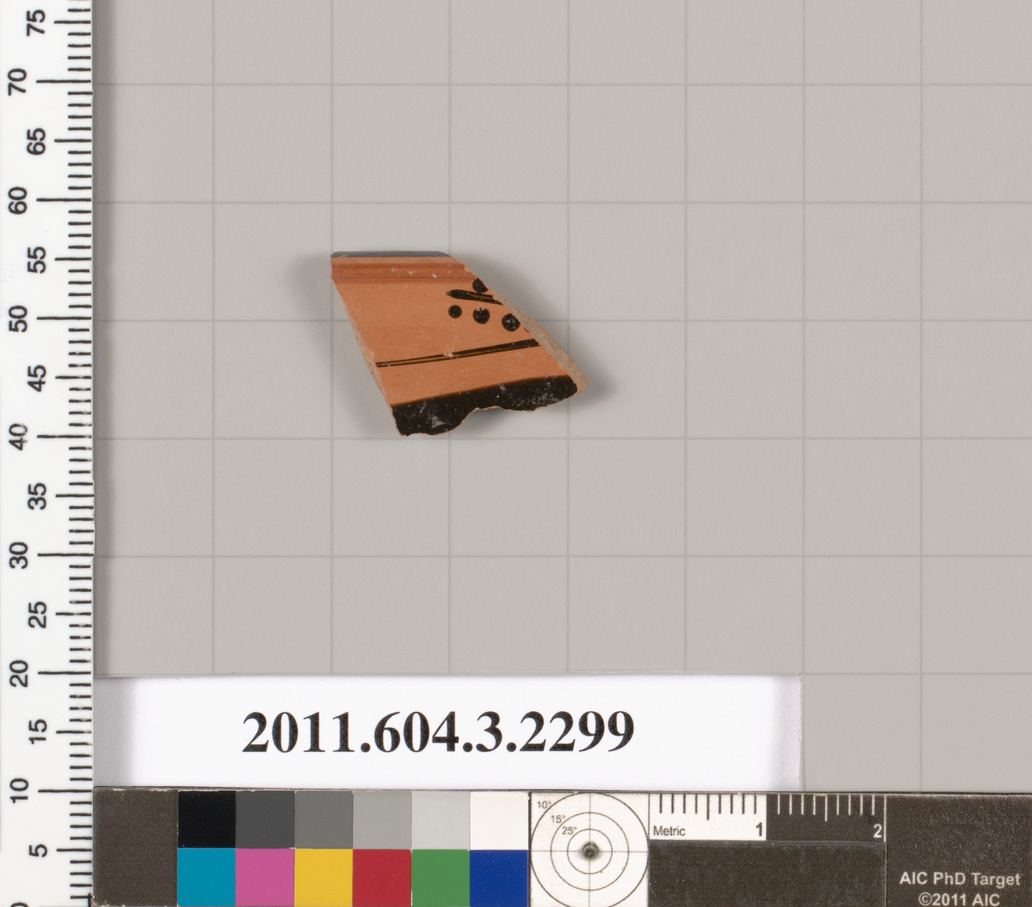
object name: kylix fragment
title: Terracotta rim fragment of a kylix: eye-cup (drinking cup)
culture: greek, attic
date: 530-500 BCE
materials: terracotta